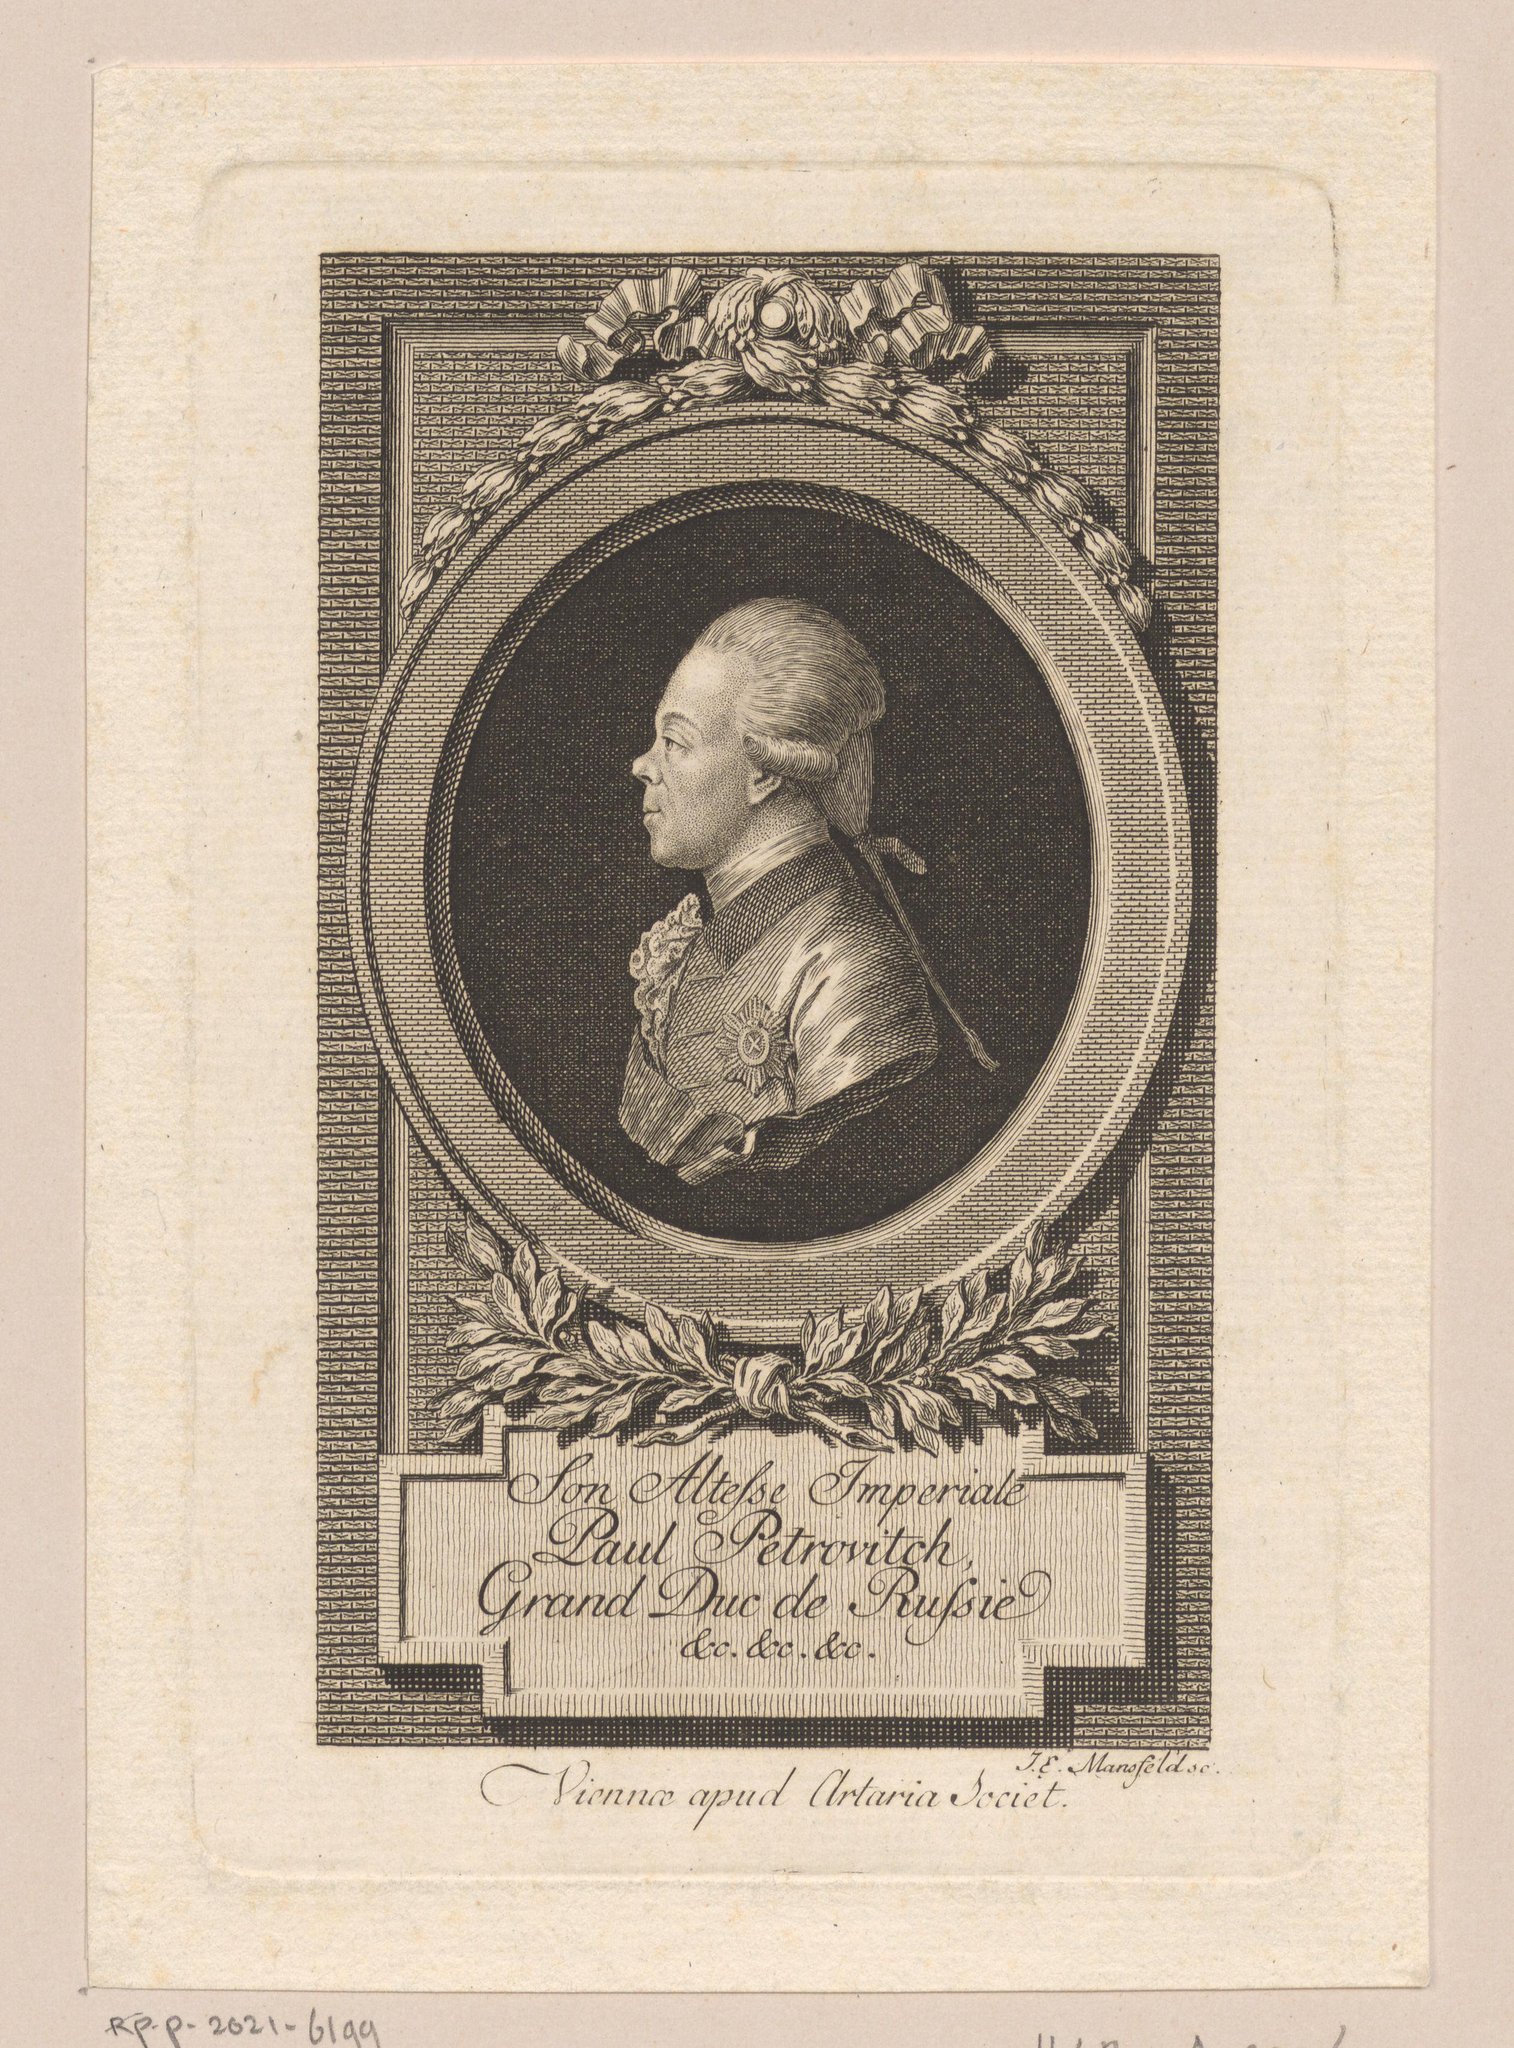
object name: print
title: Portret van Paul Petrovitsj, de latere Paul I, tsaar van Rusland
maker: johann ernst mansfeld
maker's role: print maker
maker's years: 1739-1796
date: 1767-1796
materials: paper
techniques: engraving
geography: vienna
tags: paul i (tsaar van rusland), adult man, historical persons